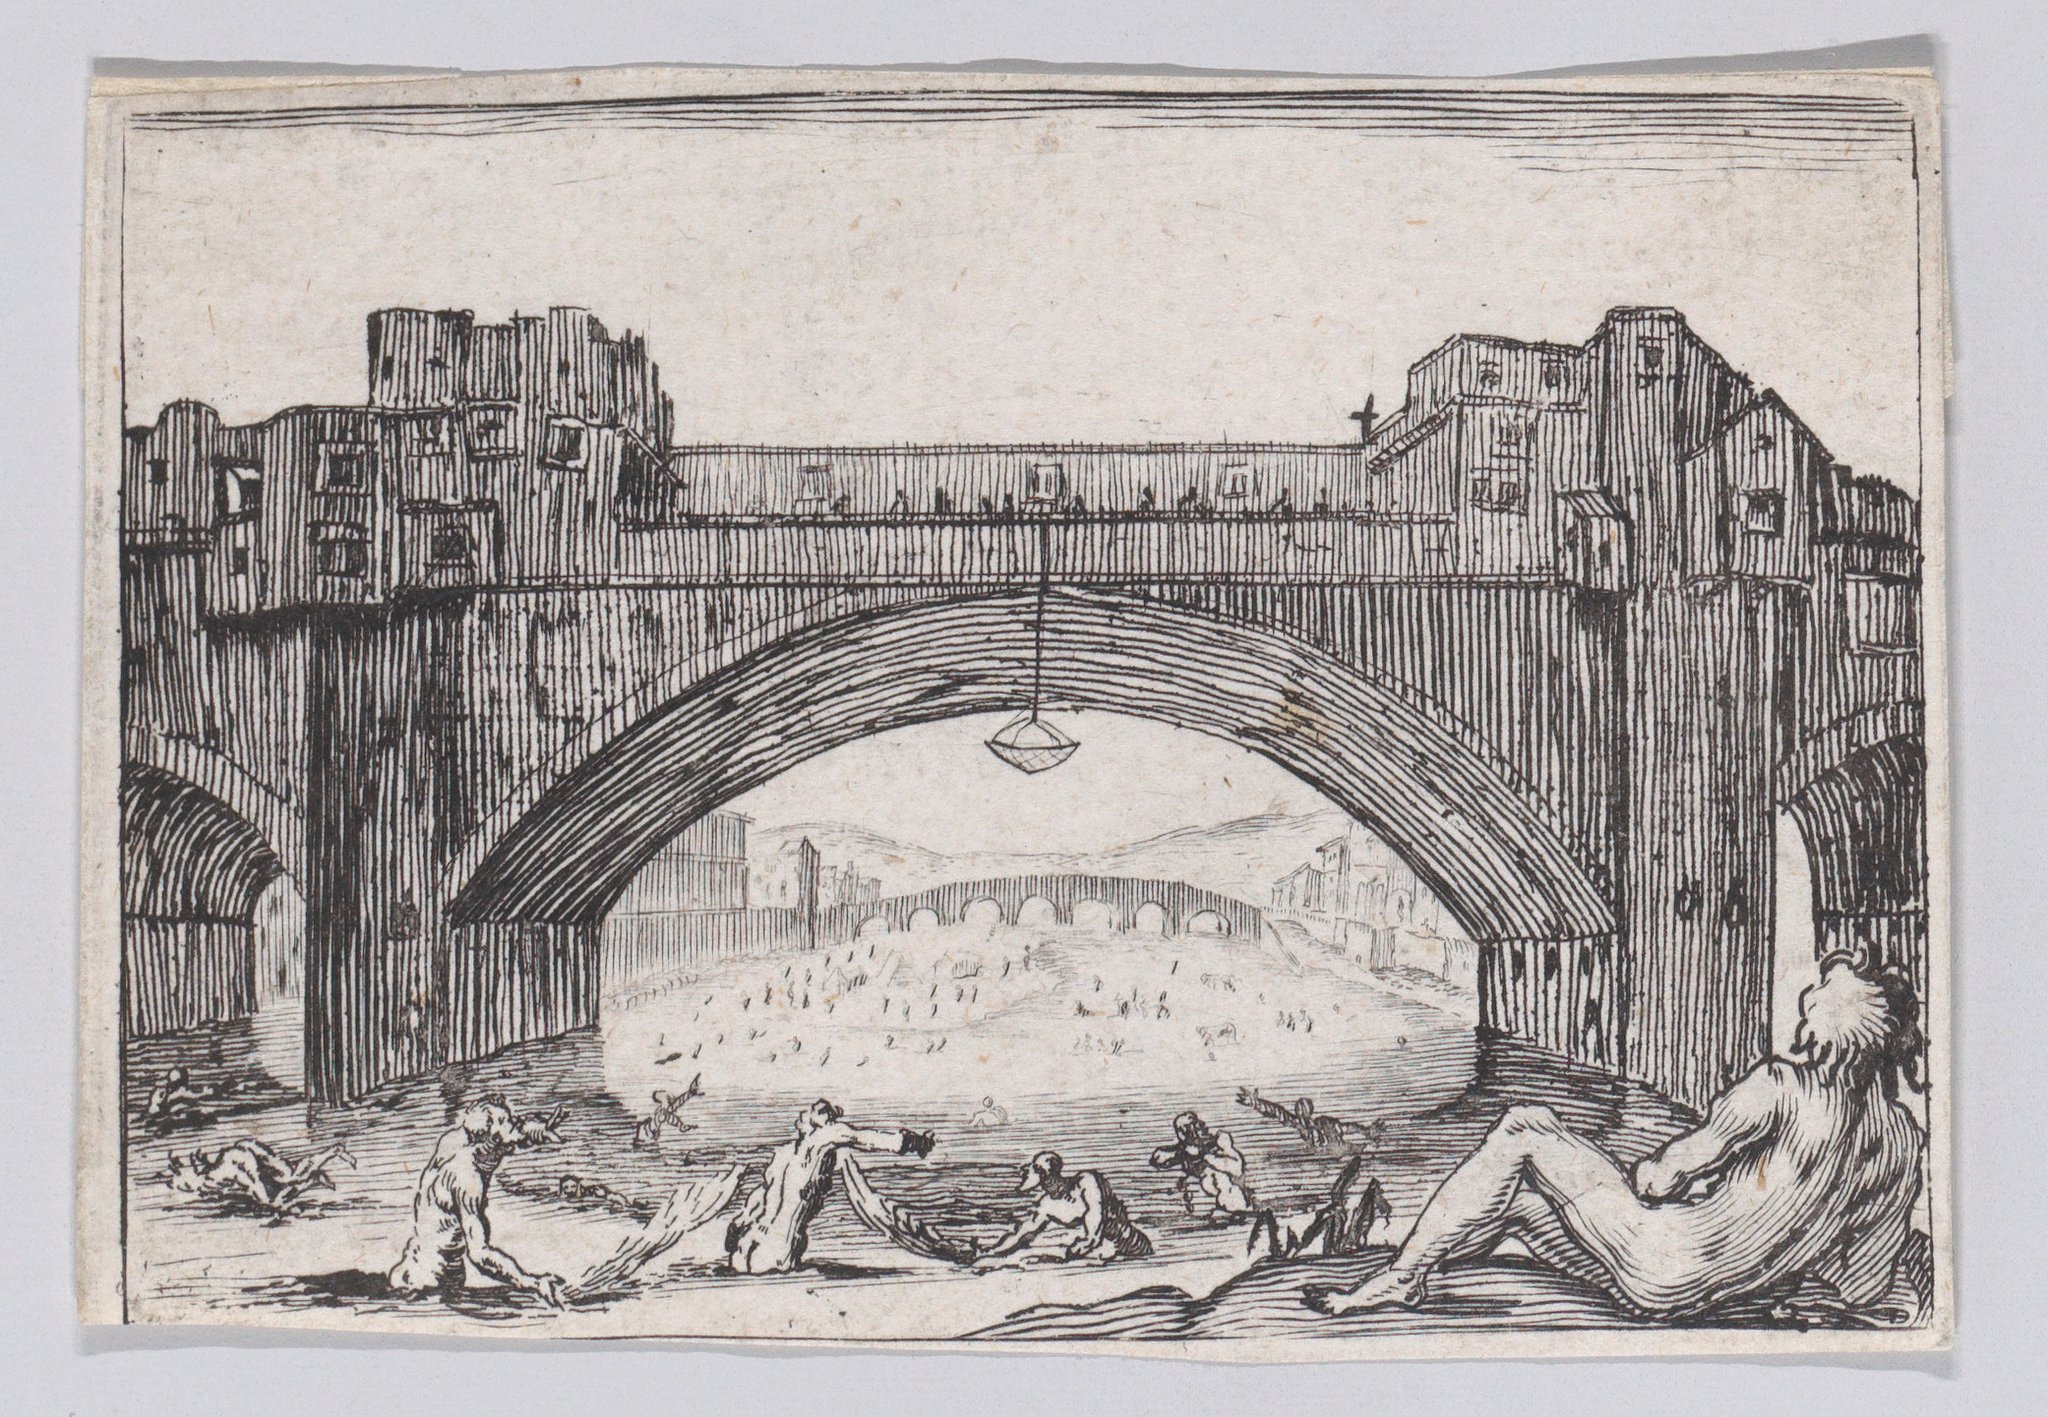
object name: print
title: Reverse Copy of Le Ponte-Vecchio, a Florence (The Ponte-Vecchio, in Florence), from "Les Caprices"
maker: Anonymous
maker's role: artist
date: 1601-1700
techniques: etching